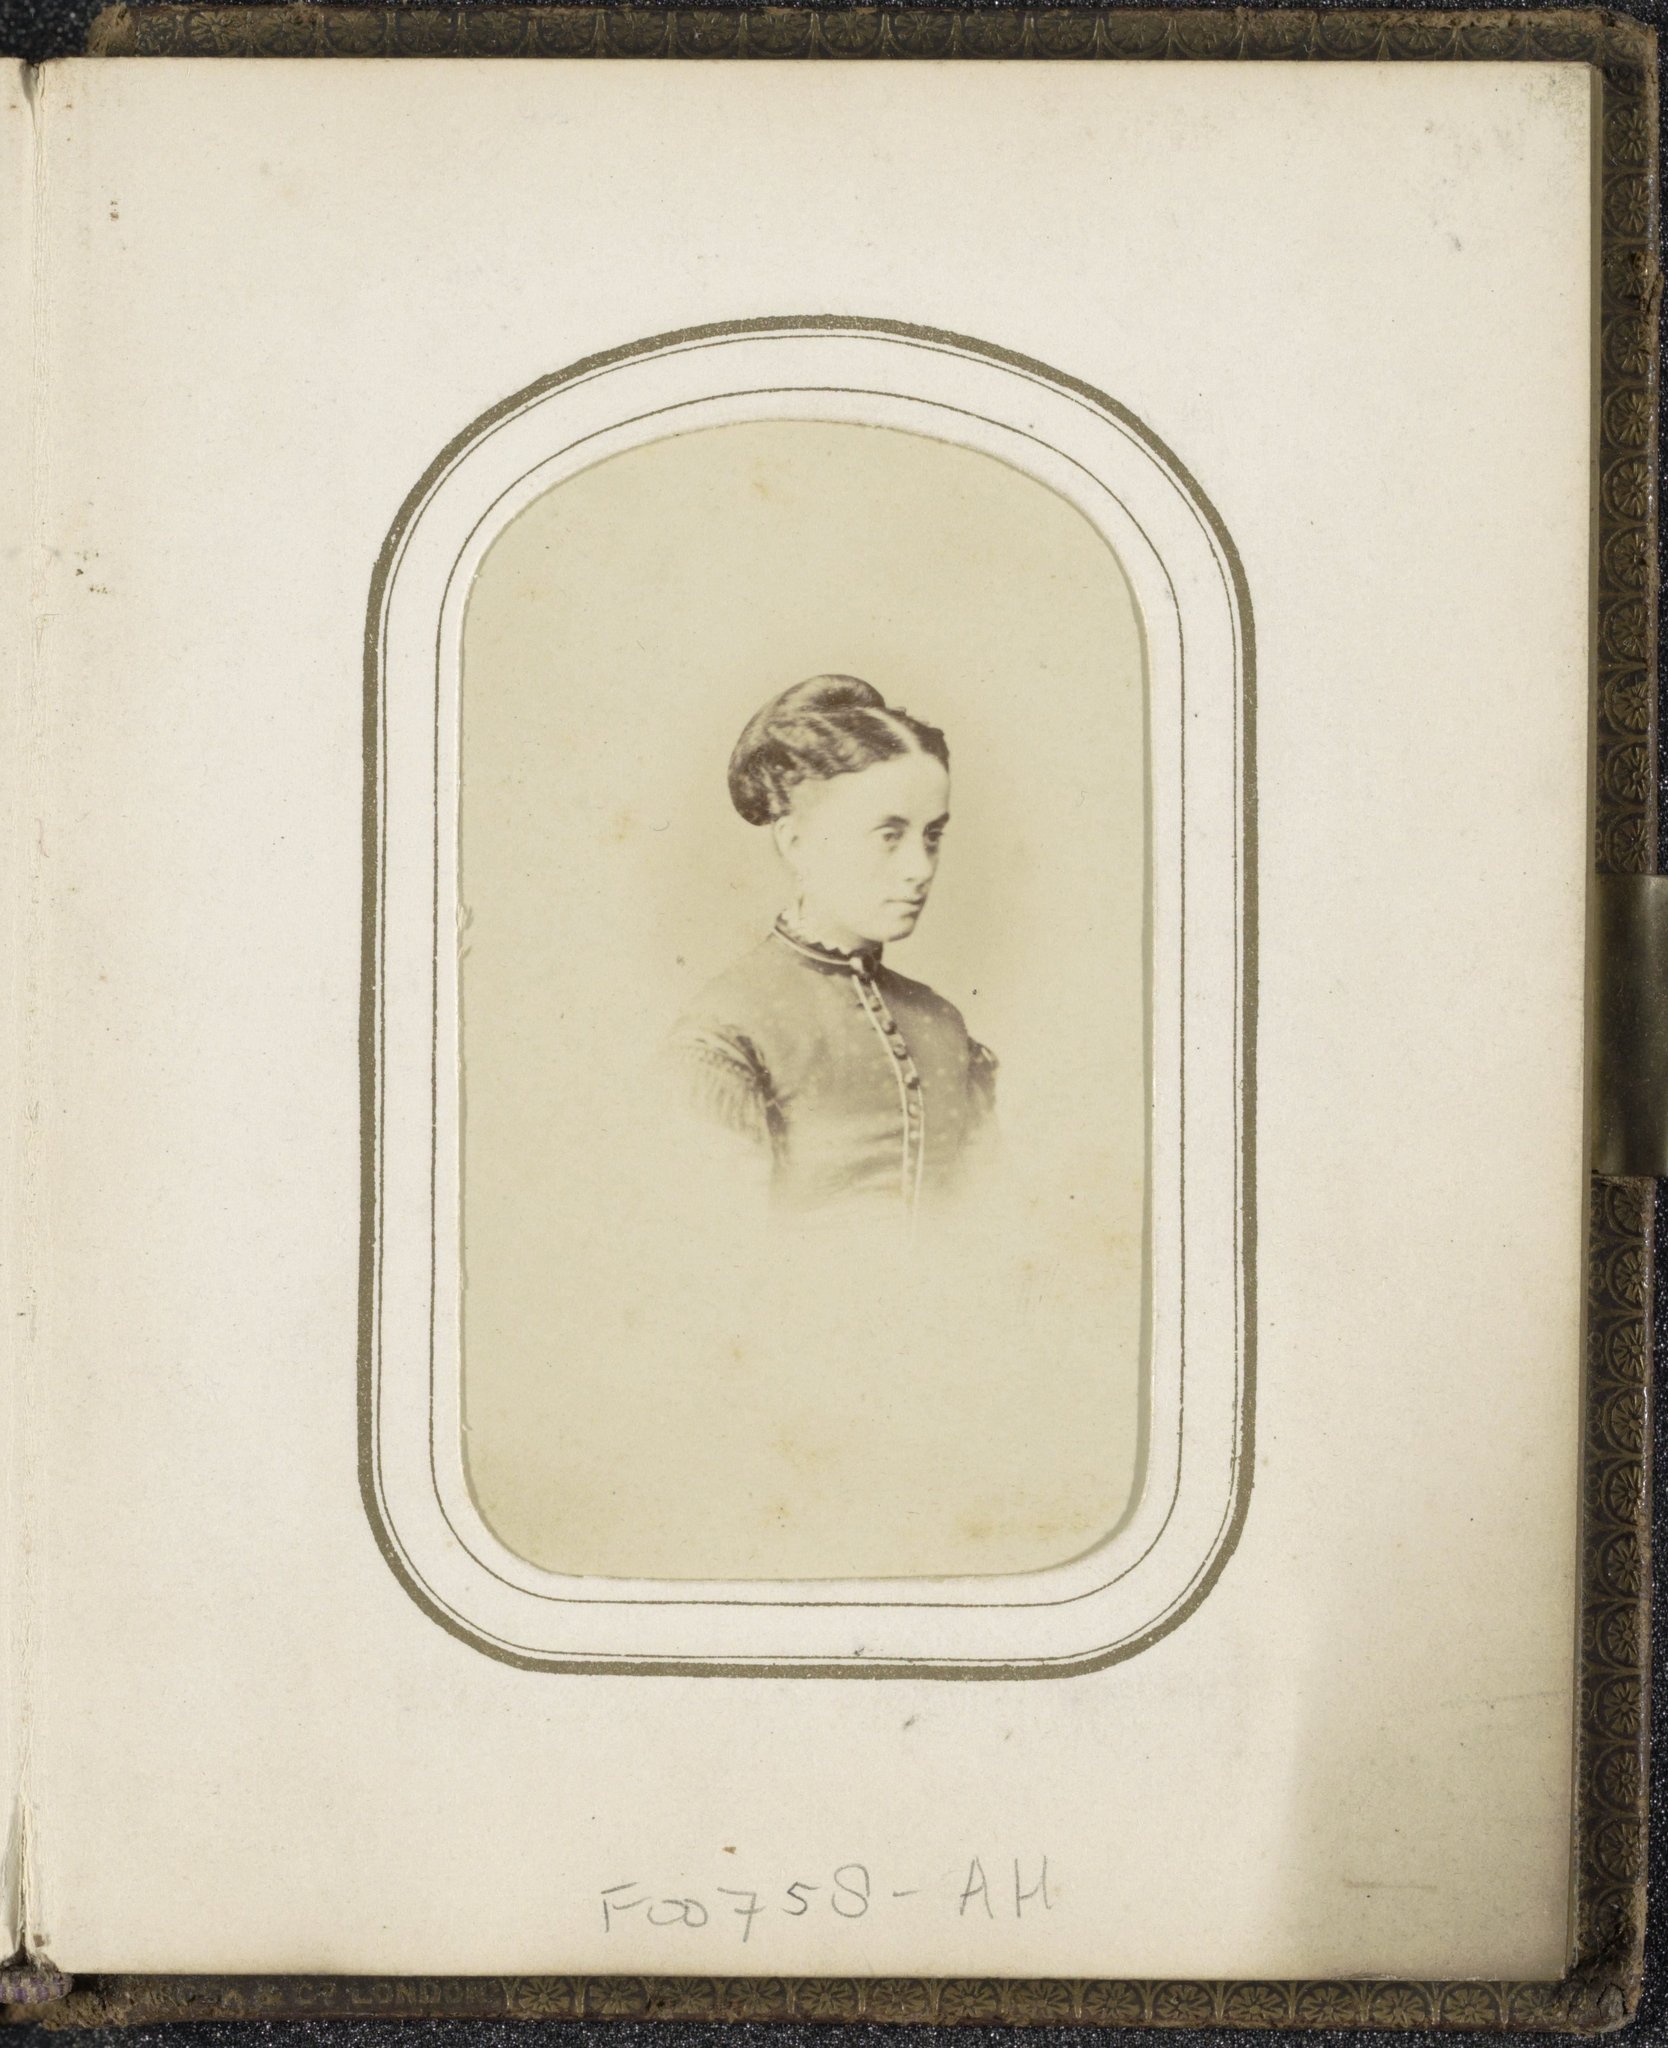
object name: carte de visite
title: Portret van een vrouw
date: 1860-1875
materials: cardboard, paper, photographic support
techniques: albumen print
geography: guildford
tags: historical persons, styles of hairdress - aa - ~ women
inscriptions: address: ‘Guildford’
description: Onderdeel van Engels fotoalbum van E.A. Kettle met 42 cartes-de-visite.